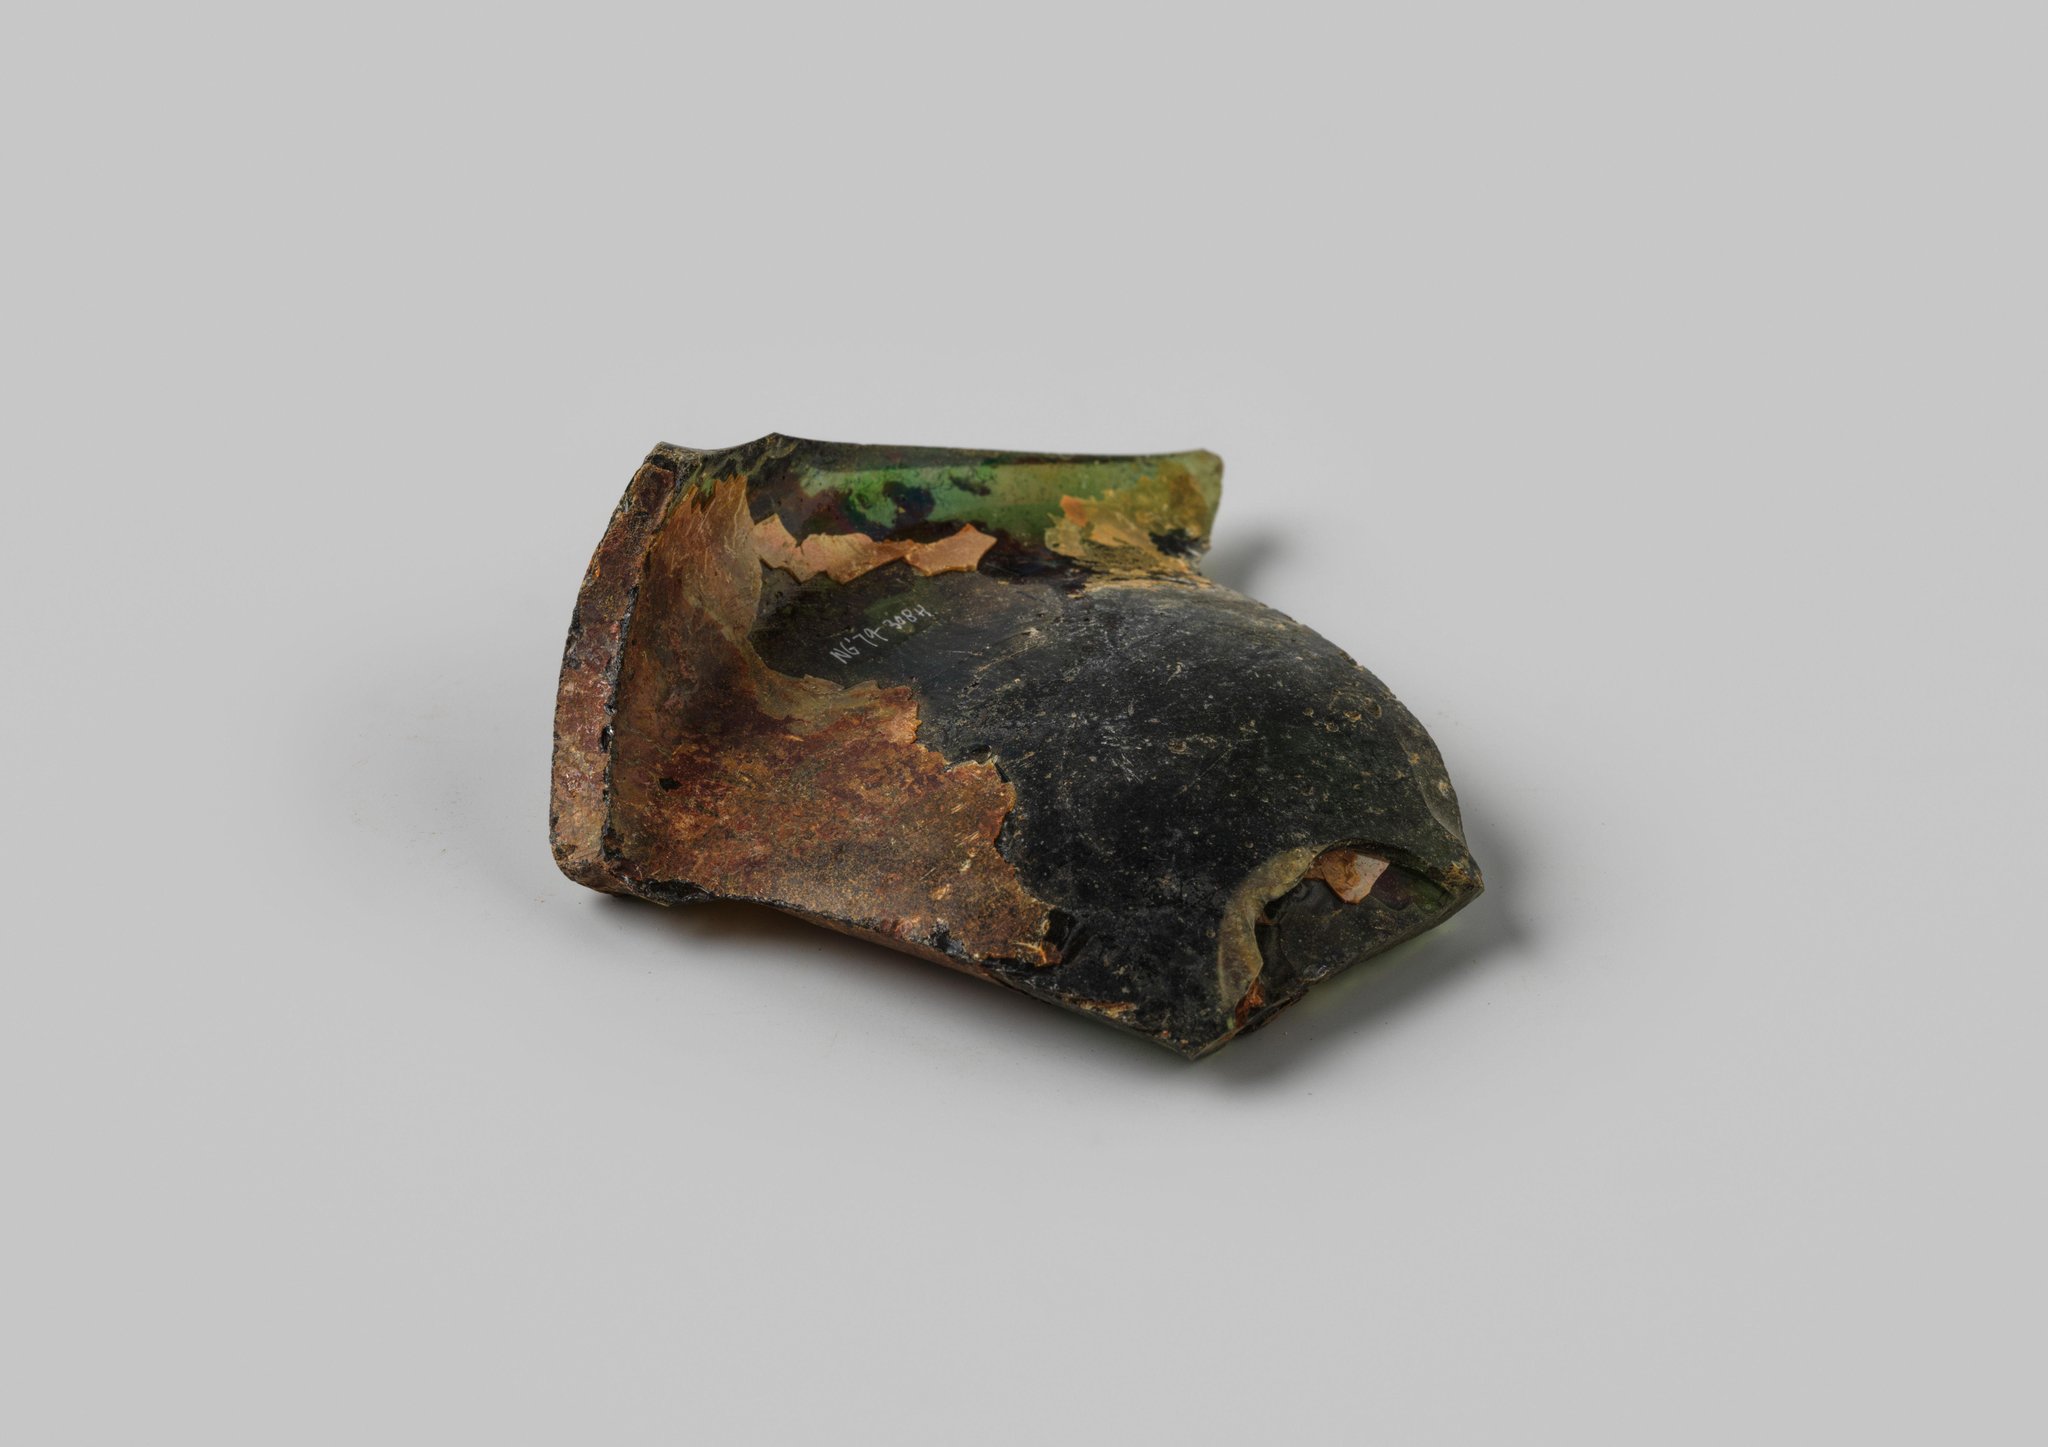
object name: wine bottle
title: Scherf van een wijnfles uit het wrak van de Oost-Indiëvaarder Hollandia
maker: Anonymous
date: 1700-1743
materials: glass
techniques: green glass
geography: netherlands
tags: verenigde oostindische compagnie, hollandia (schip), annet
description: Typologically not identifiable, base, fragm.